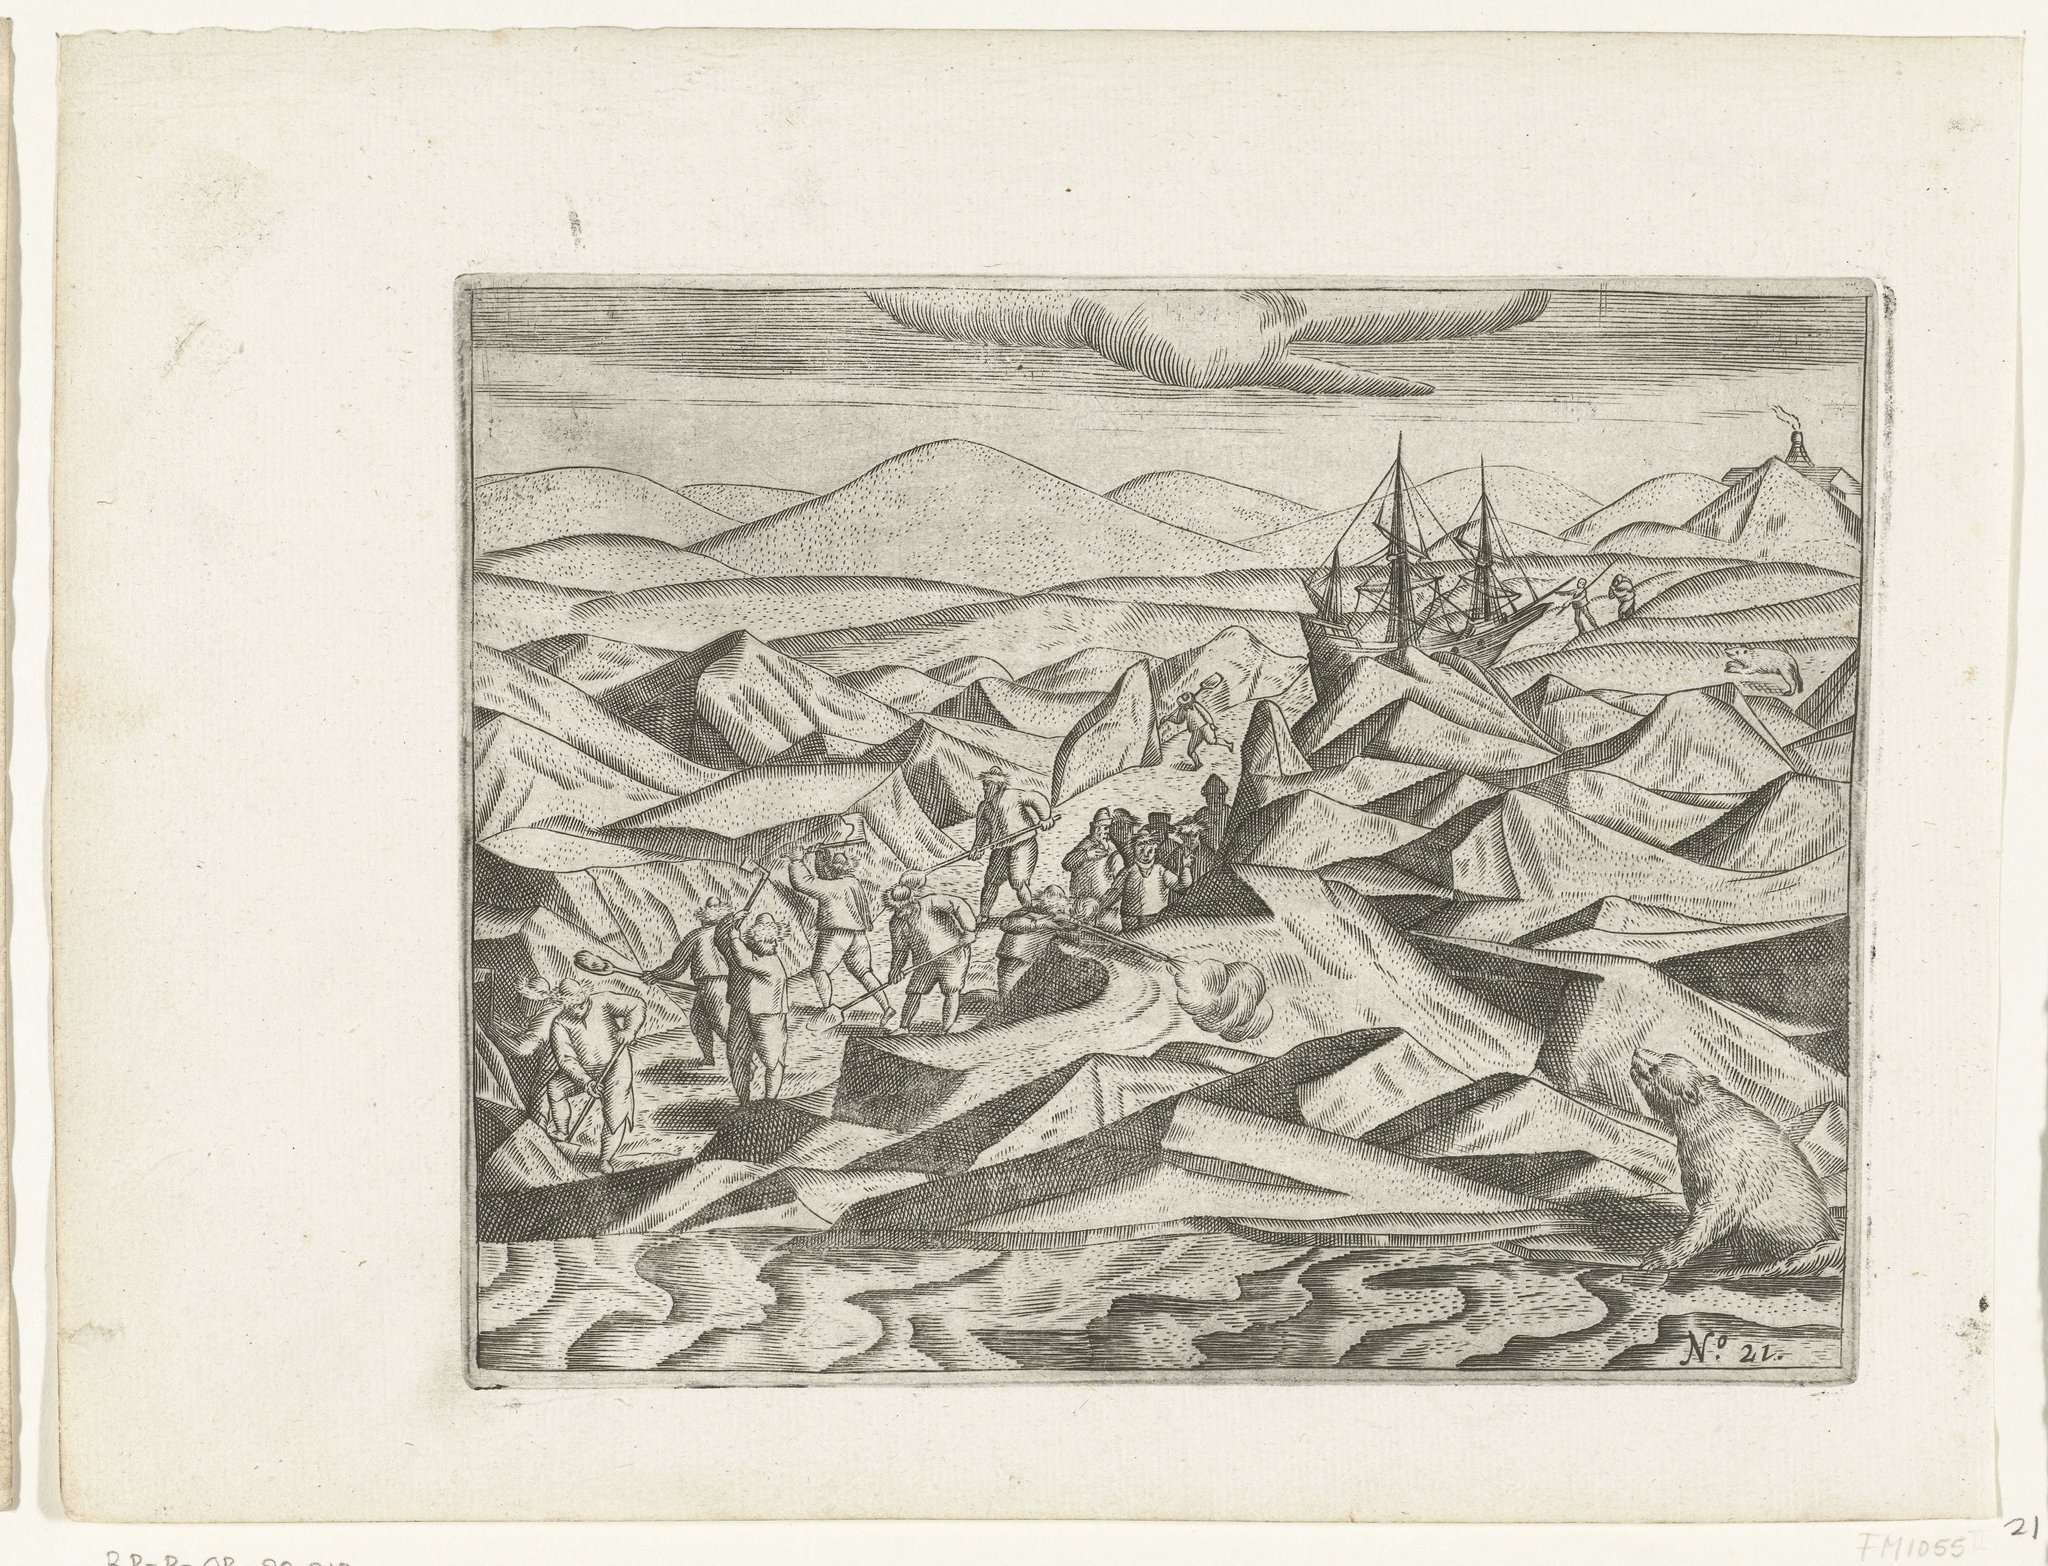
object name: print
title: Het vrijmaken van een pad door het ijs naar de zee, 1597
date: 1615-1617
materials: paper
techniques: engraving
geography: northern netherlands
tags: willem barendsz., amsterdam, jacob van heemskerck, landscapes in polar regions, exploration, expedition, voyage of discovery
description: Gebruikt als illustratie eerst in: G. de Veer, De waerachtige beschrijvinge vande drie seylagien, drie jaren achter mal-kanderen deur de Hollandtsche ende Zeelandtsche Schepen, by noorden Noorweghen, Moscovien ende tartarien nae de Coninckrijcken van Catthay ende China ghedaene, [Michiel Colijn, Amsterdam 1617]. Later gebruikt in: Kort verhael van d'eerste Schipvaerd der Hollandsche ende Zeeusche Schepen by noorden Noorwegen, Moscovien ende Tartarien om, nae de Coningrijcken van Cathay ende China, getogen uyt het Journael van Gerrit de Veer. Opgenomen in: I. Commelin, Begin ende voortgangh, van de Vereenighde Nederlantsche Geoctroyeerde Oost-Indische Compagnie, J. Janssonius, Amsterdam 1646. Genummerd: No. 21.